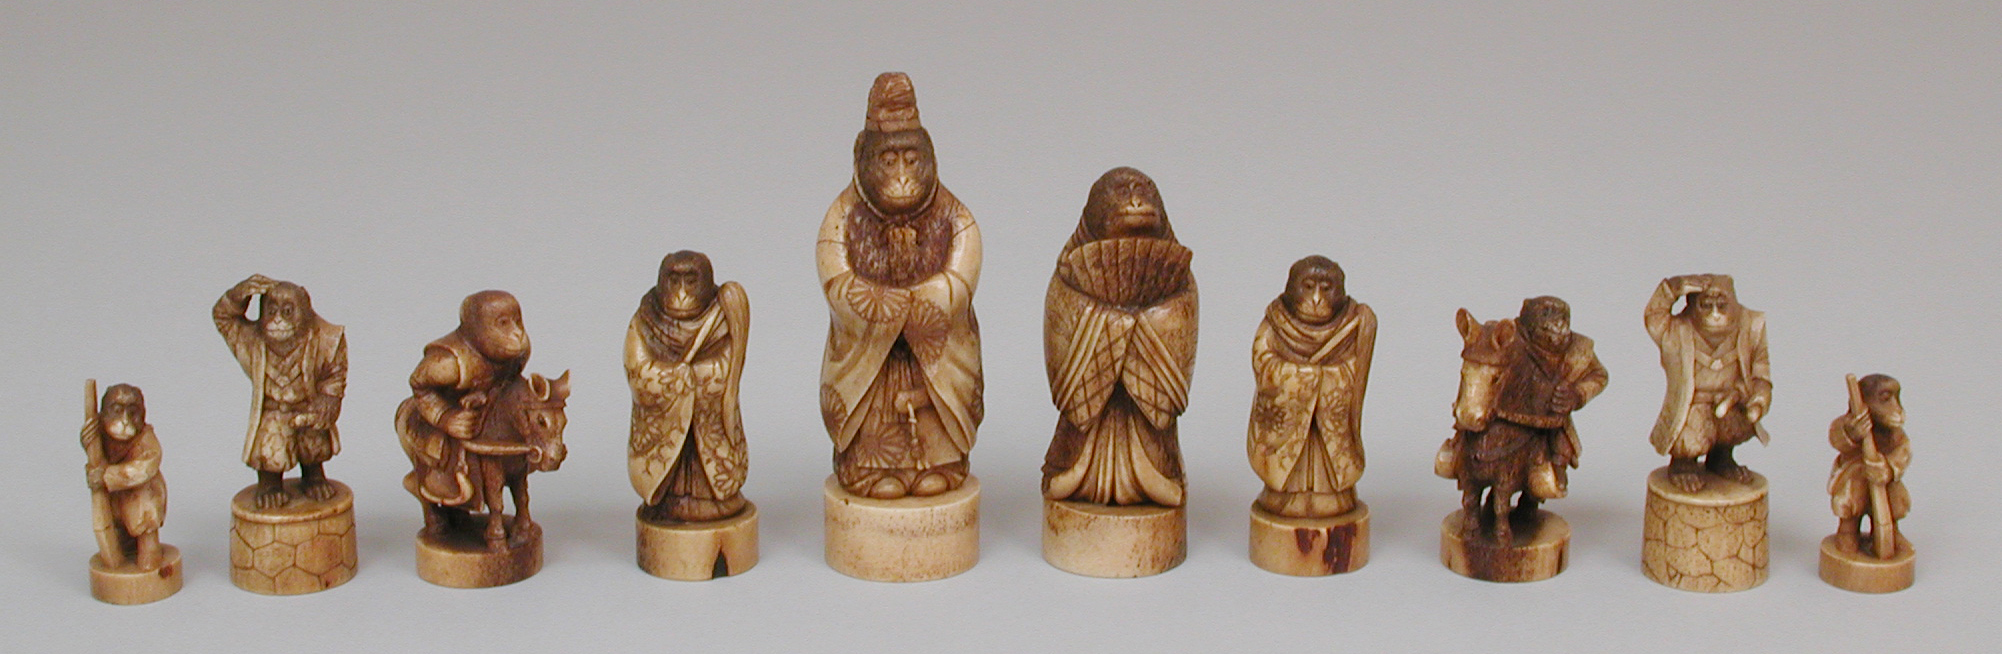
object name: chessman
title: Chessmen (32) in the form of anthropomorphized monkeys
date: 1801-1900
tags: chess